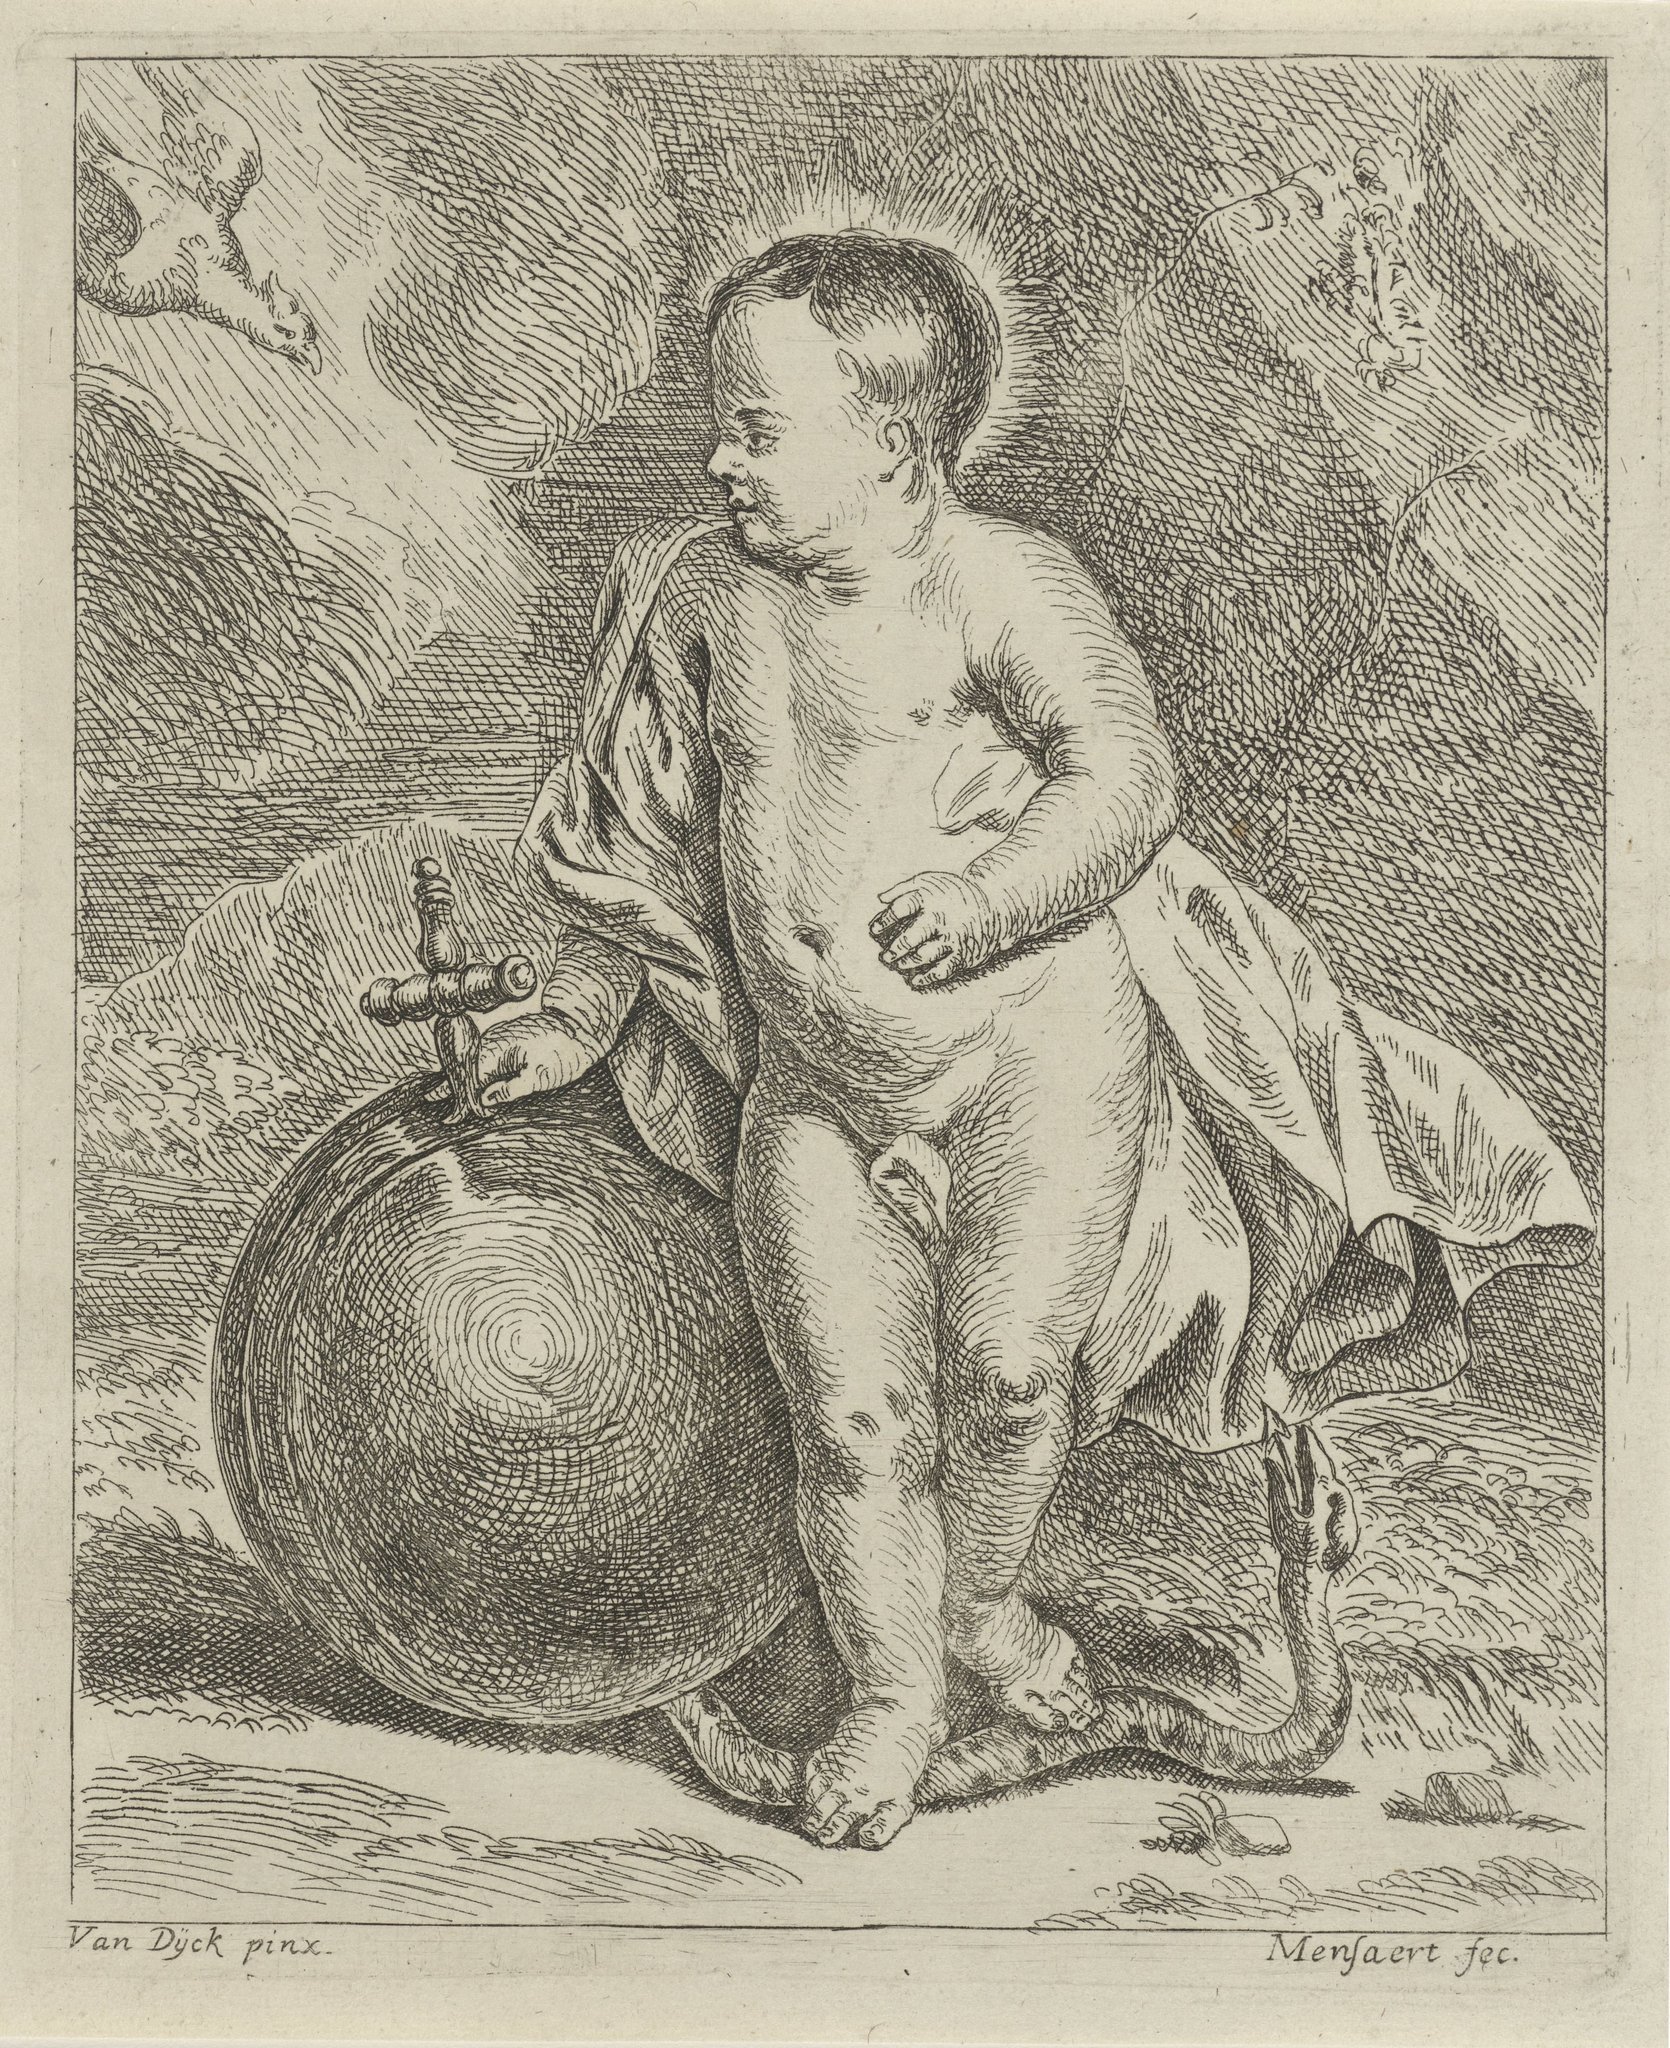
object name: print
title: Christuskind met wereldbol en slang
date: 1721-1777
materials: paper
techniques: etching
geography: brussels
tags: 'salvator mundi', making a blessing gesture; an orb in his hand or at his feet, christ as child or youth (in general) ~ christian religion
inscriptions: collector's mark: Lugt 240